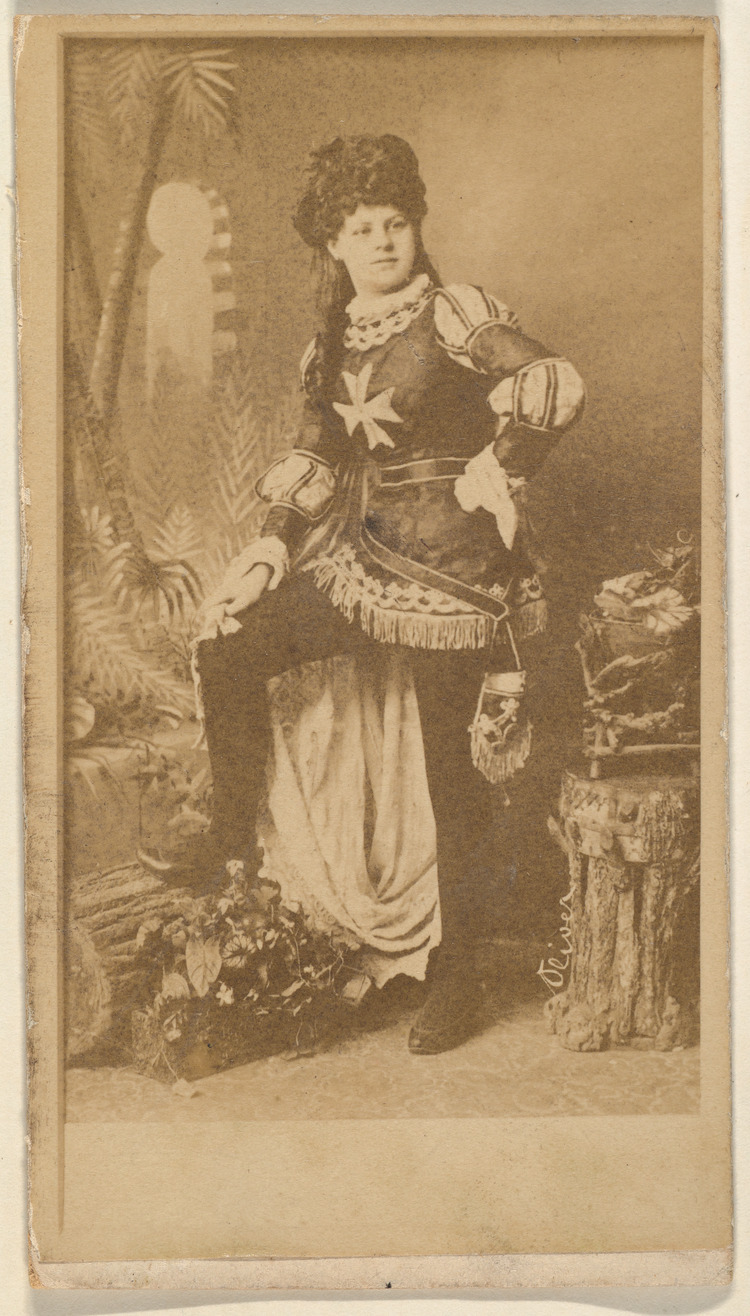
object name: photograph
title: Actress wearing military-inspired costume, from the Actresses series (N668)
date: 1888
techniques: albumen silver print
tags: portraits,women,actresses